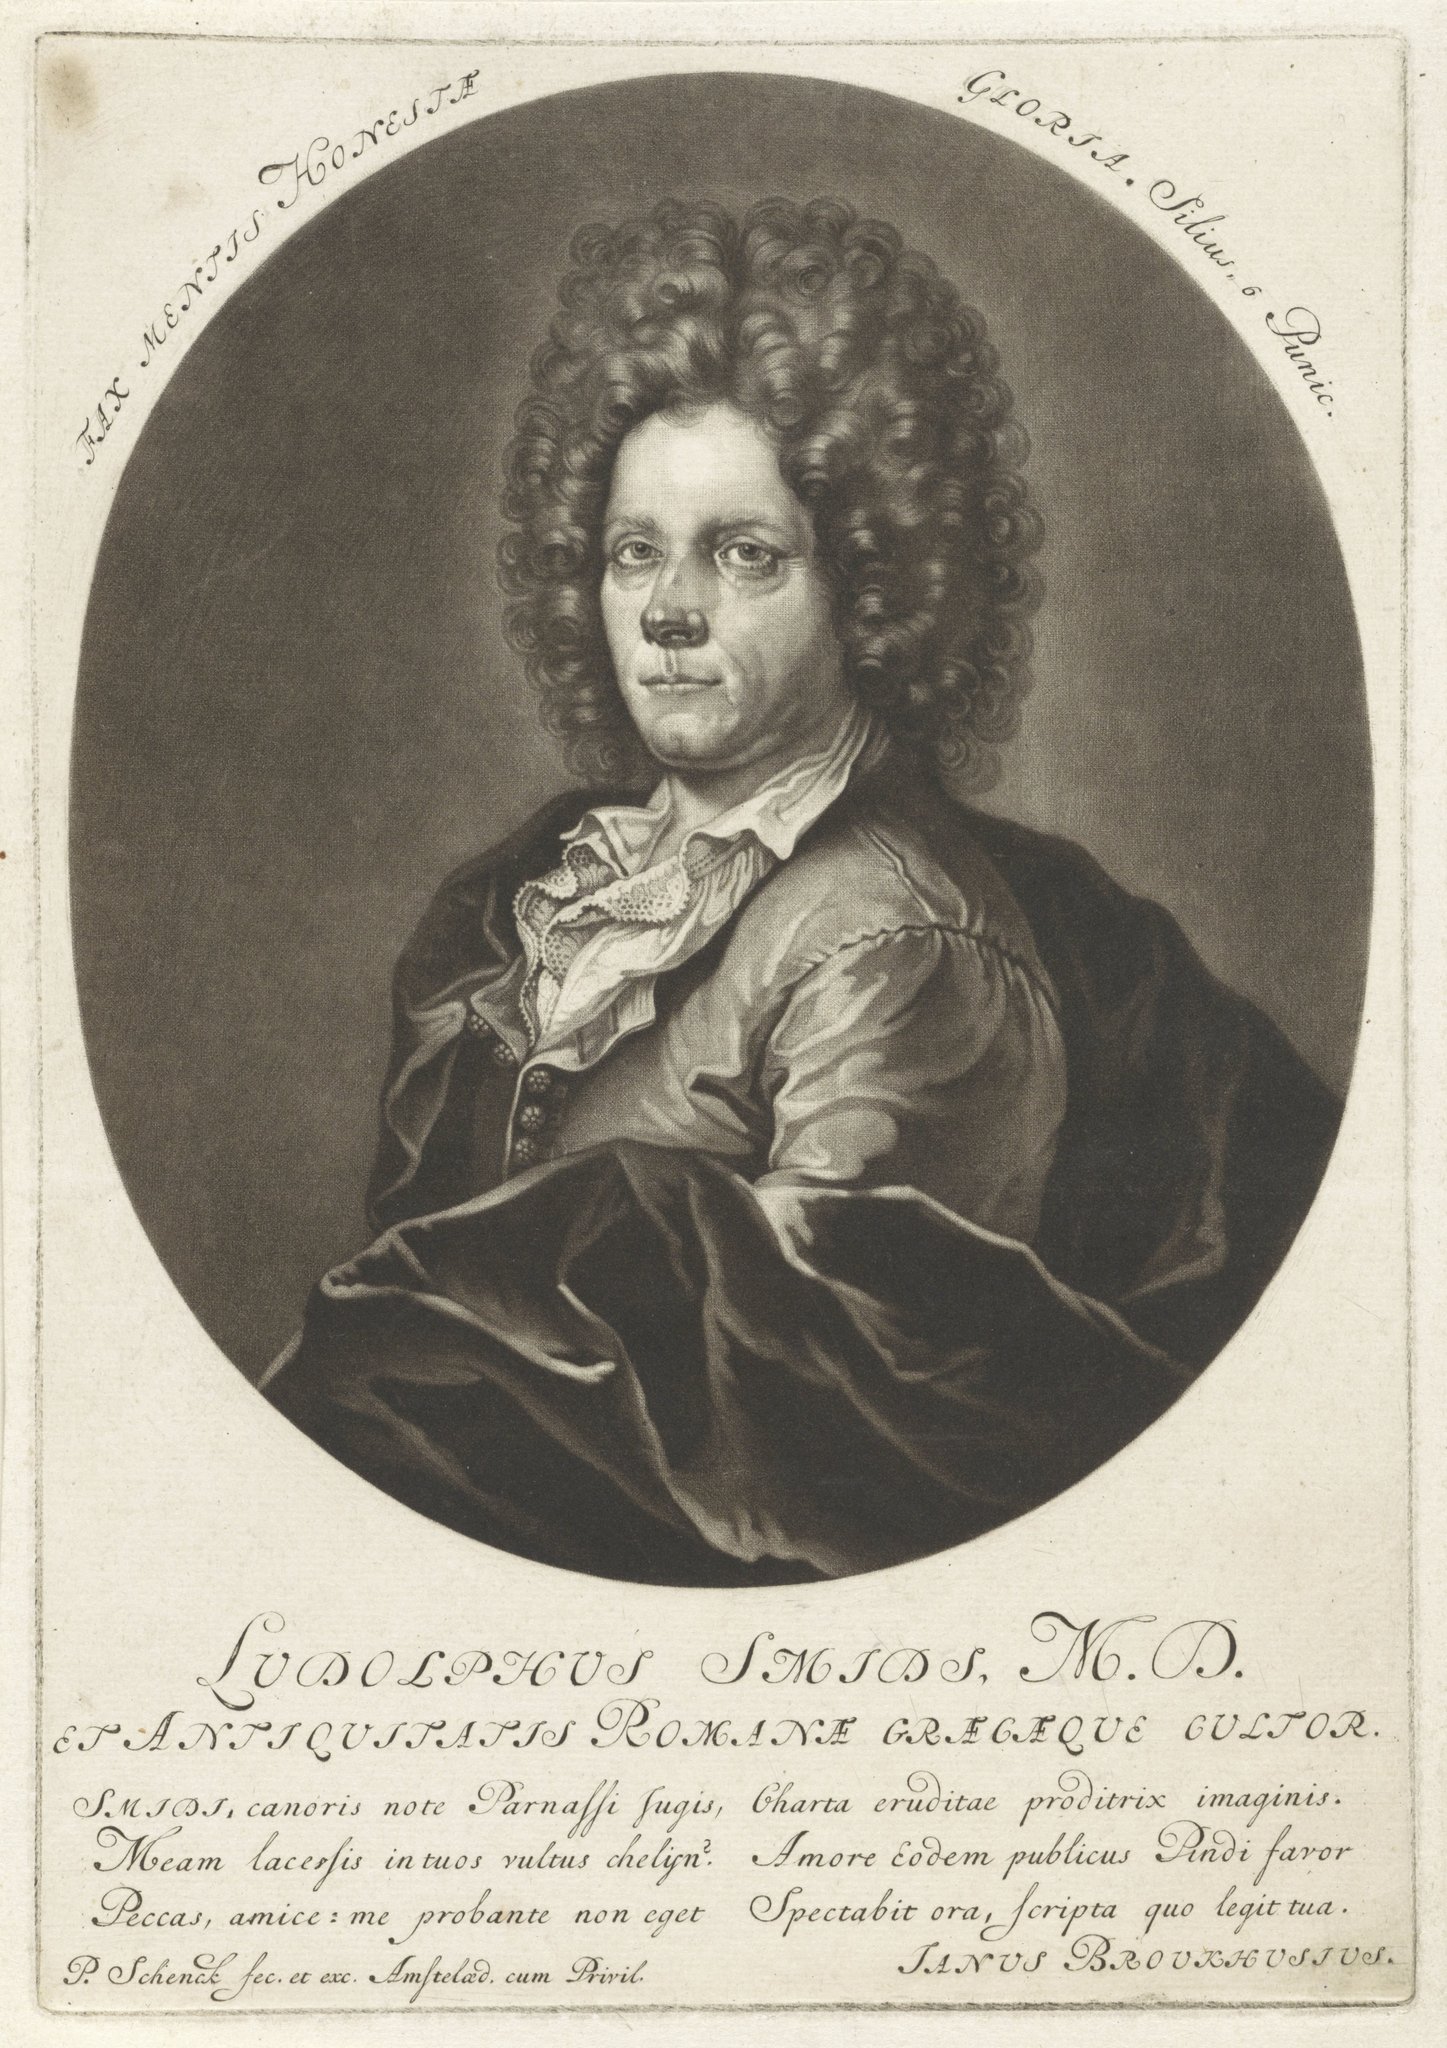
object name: print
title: Portret van Ludolph Smids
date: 1670-1713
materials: paper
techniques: engraving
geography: amsterdam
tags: ludolph smids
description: De dichter, oudheidkundige en arts Ludolph Smids.